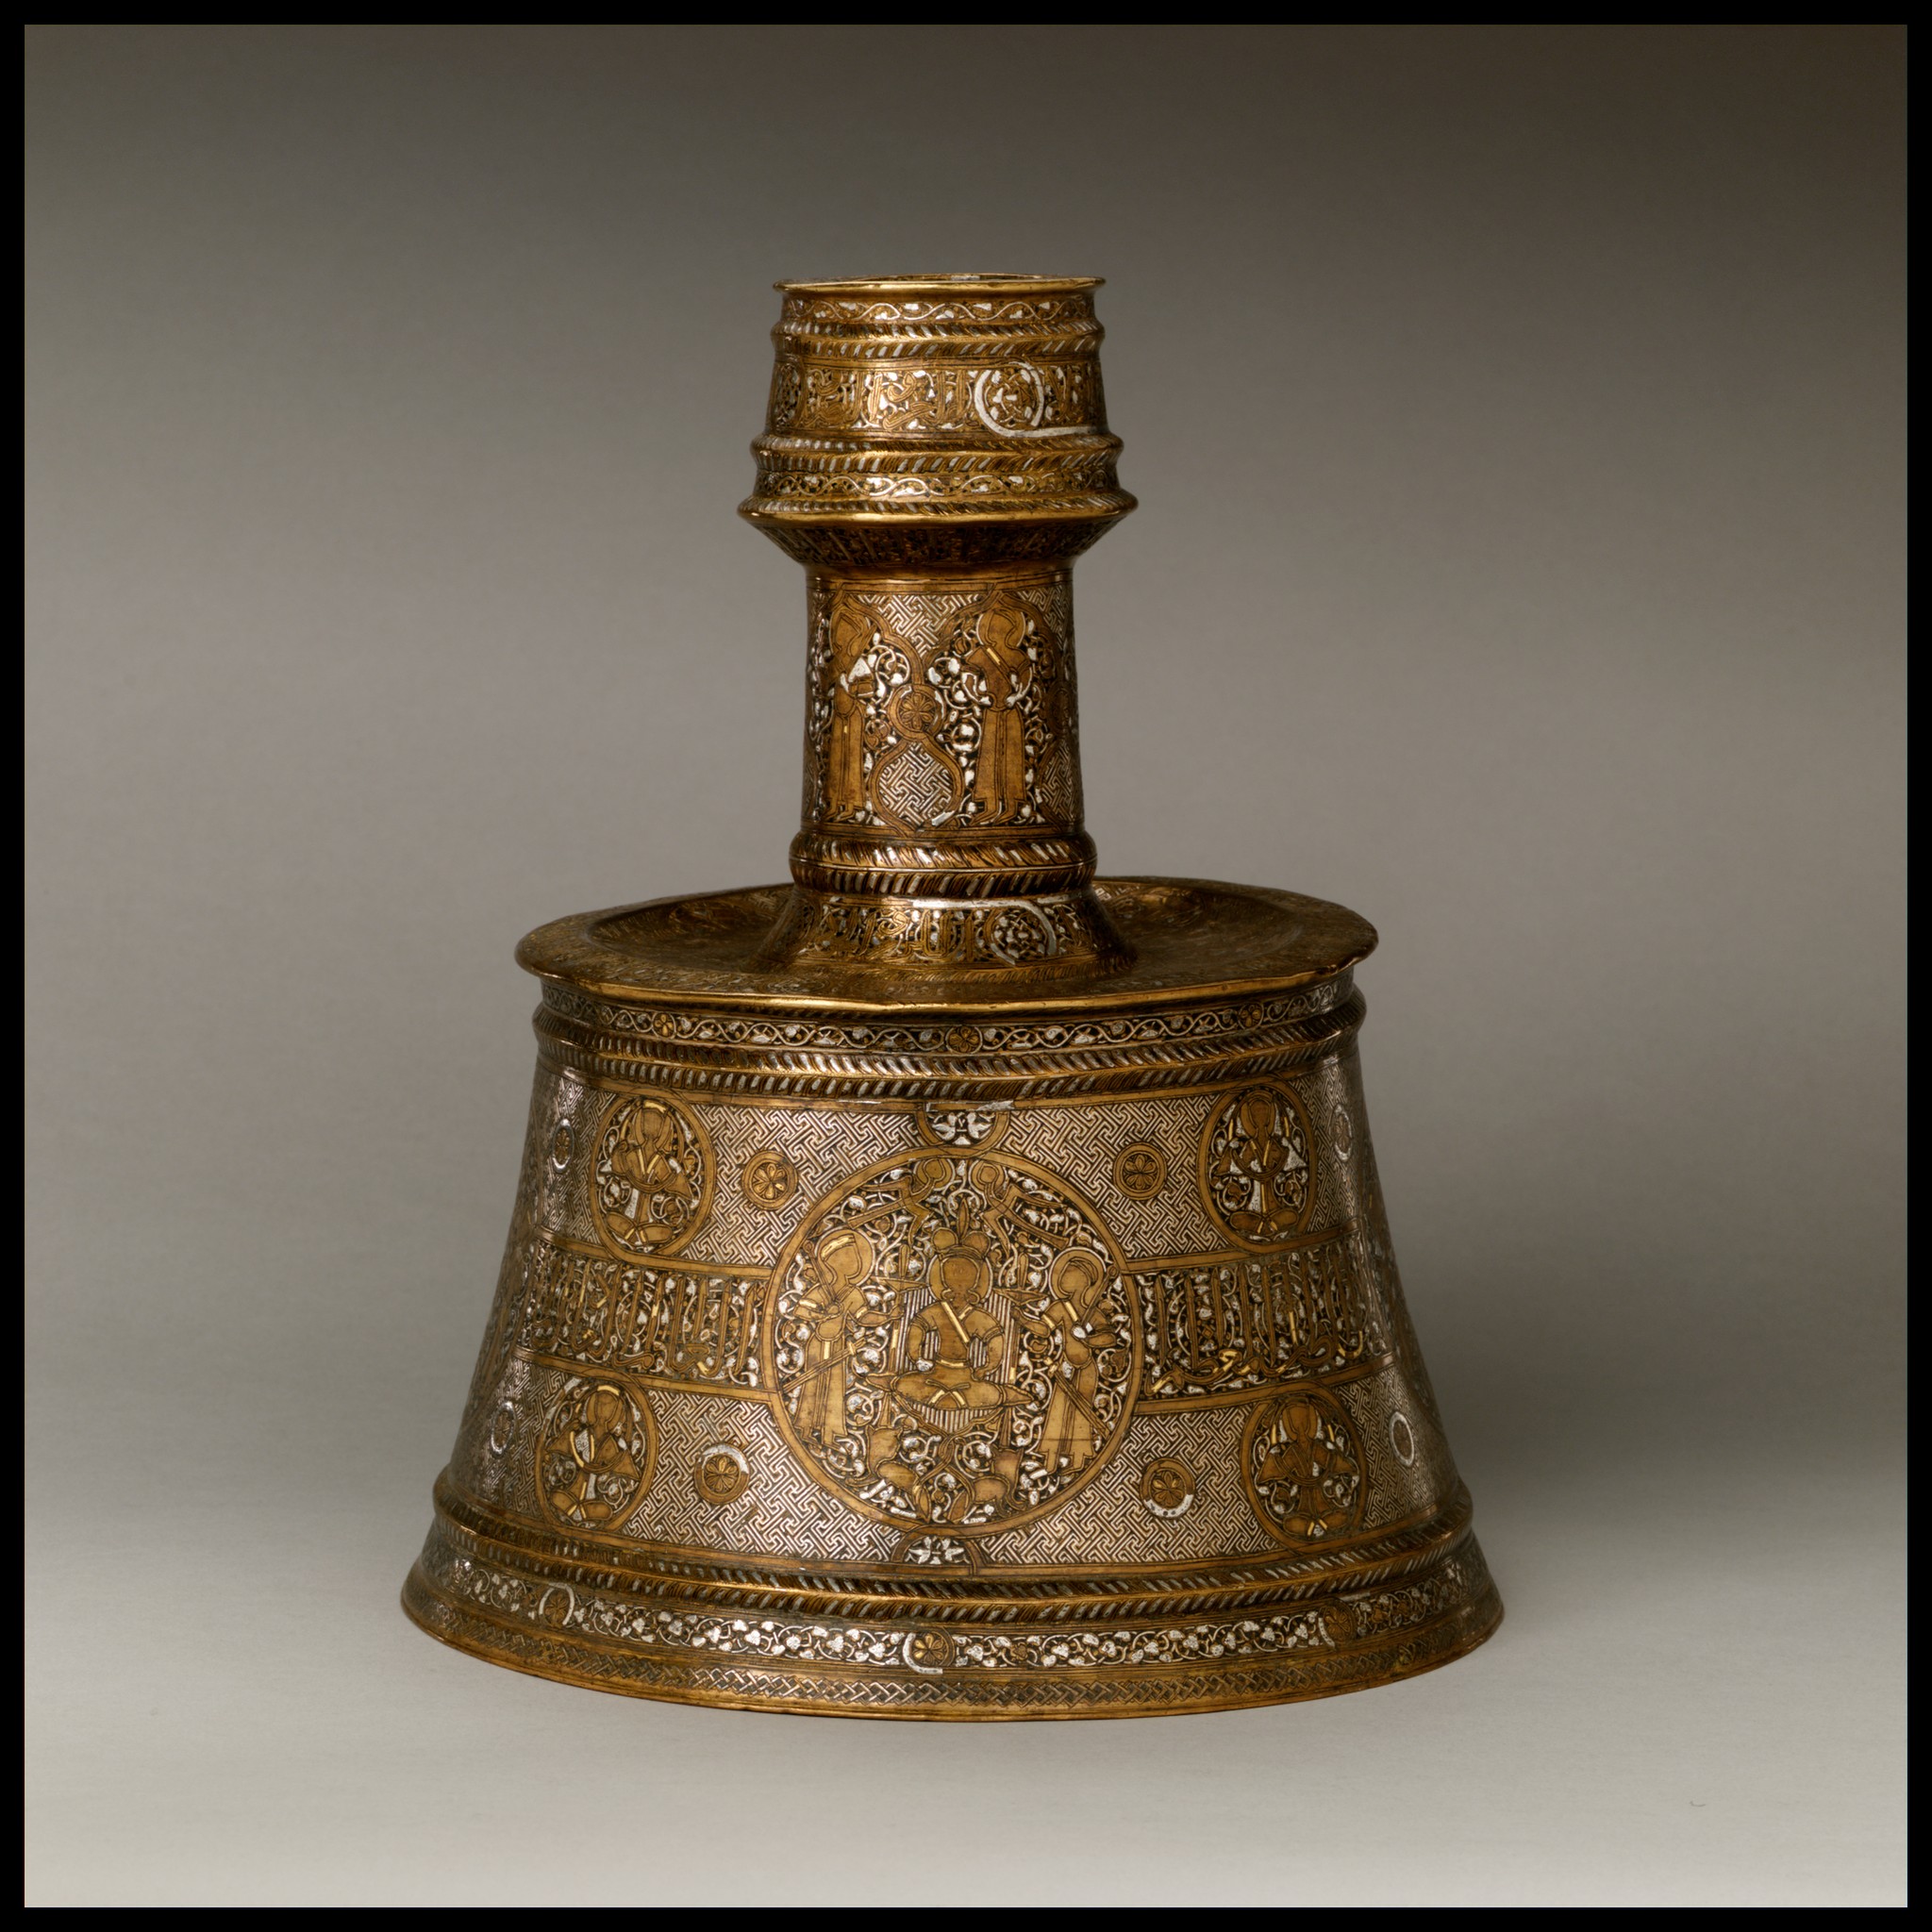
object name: candlestick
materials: brass, gold, silver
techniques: inlay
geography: western iran, northern iraq, or northern syria